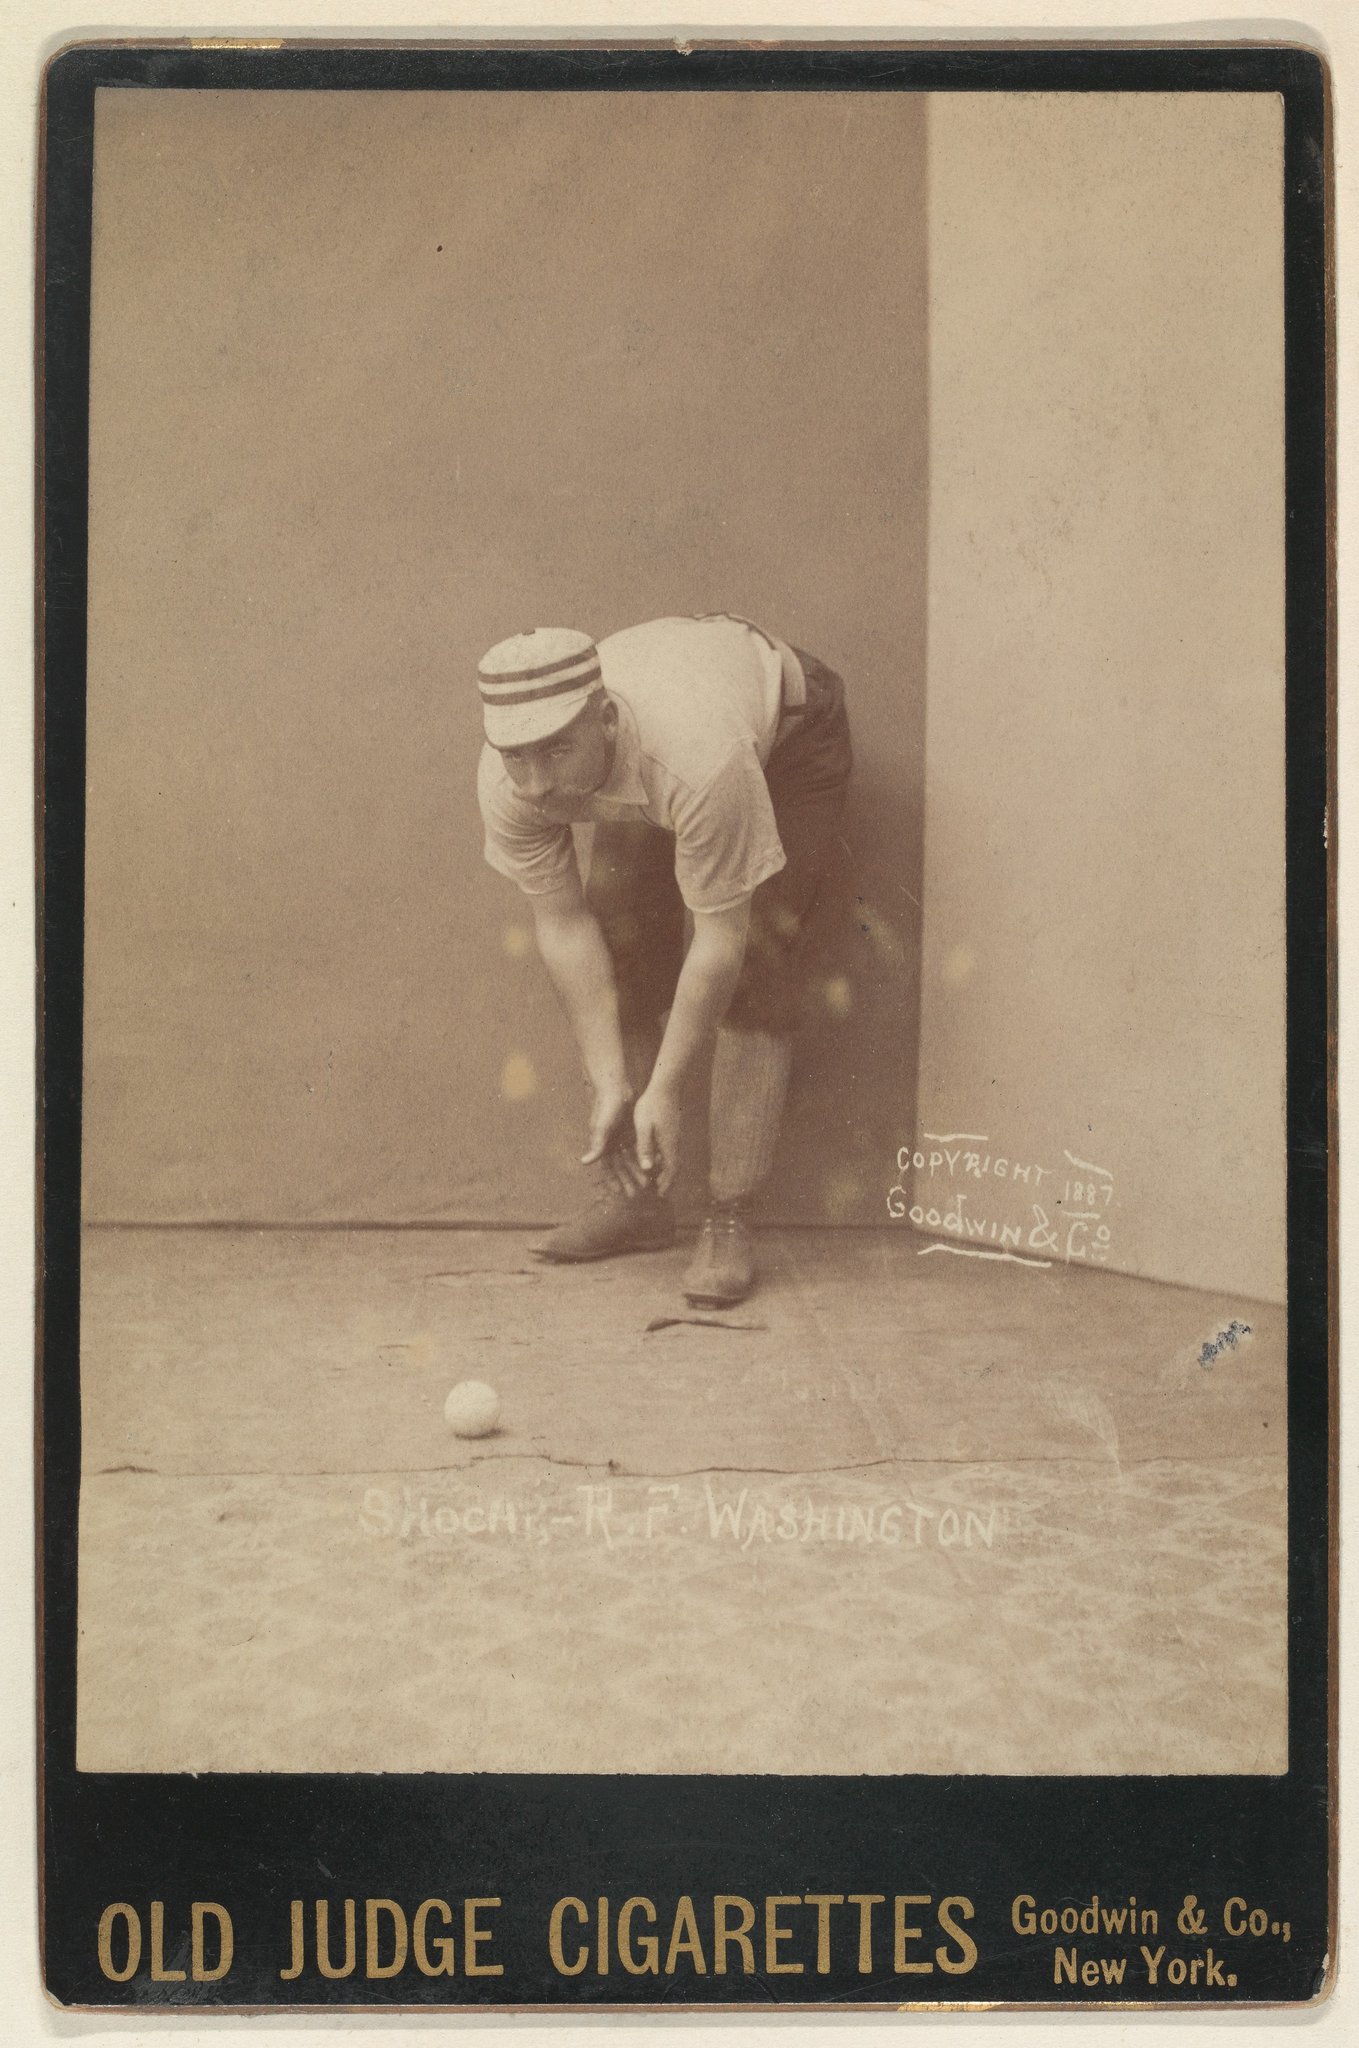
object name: baseball card, photograph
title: Shoch, Right Field, Washington, from the series Old Judge Cigarettes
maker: goodwin & company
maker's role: publisher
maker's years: 1850-1950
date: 1887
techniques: albumen print, photography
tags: men,portraits,baseball,athletes